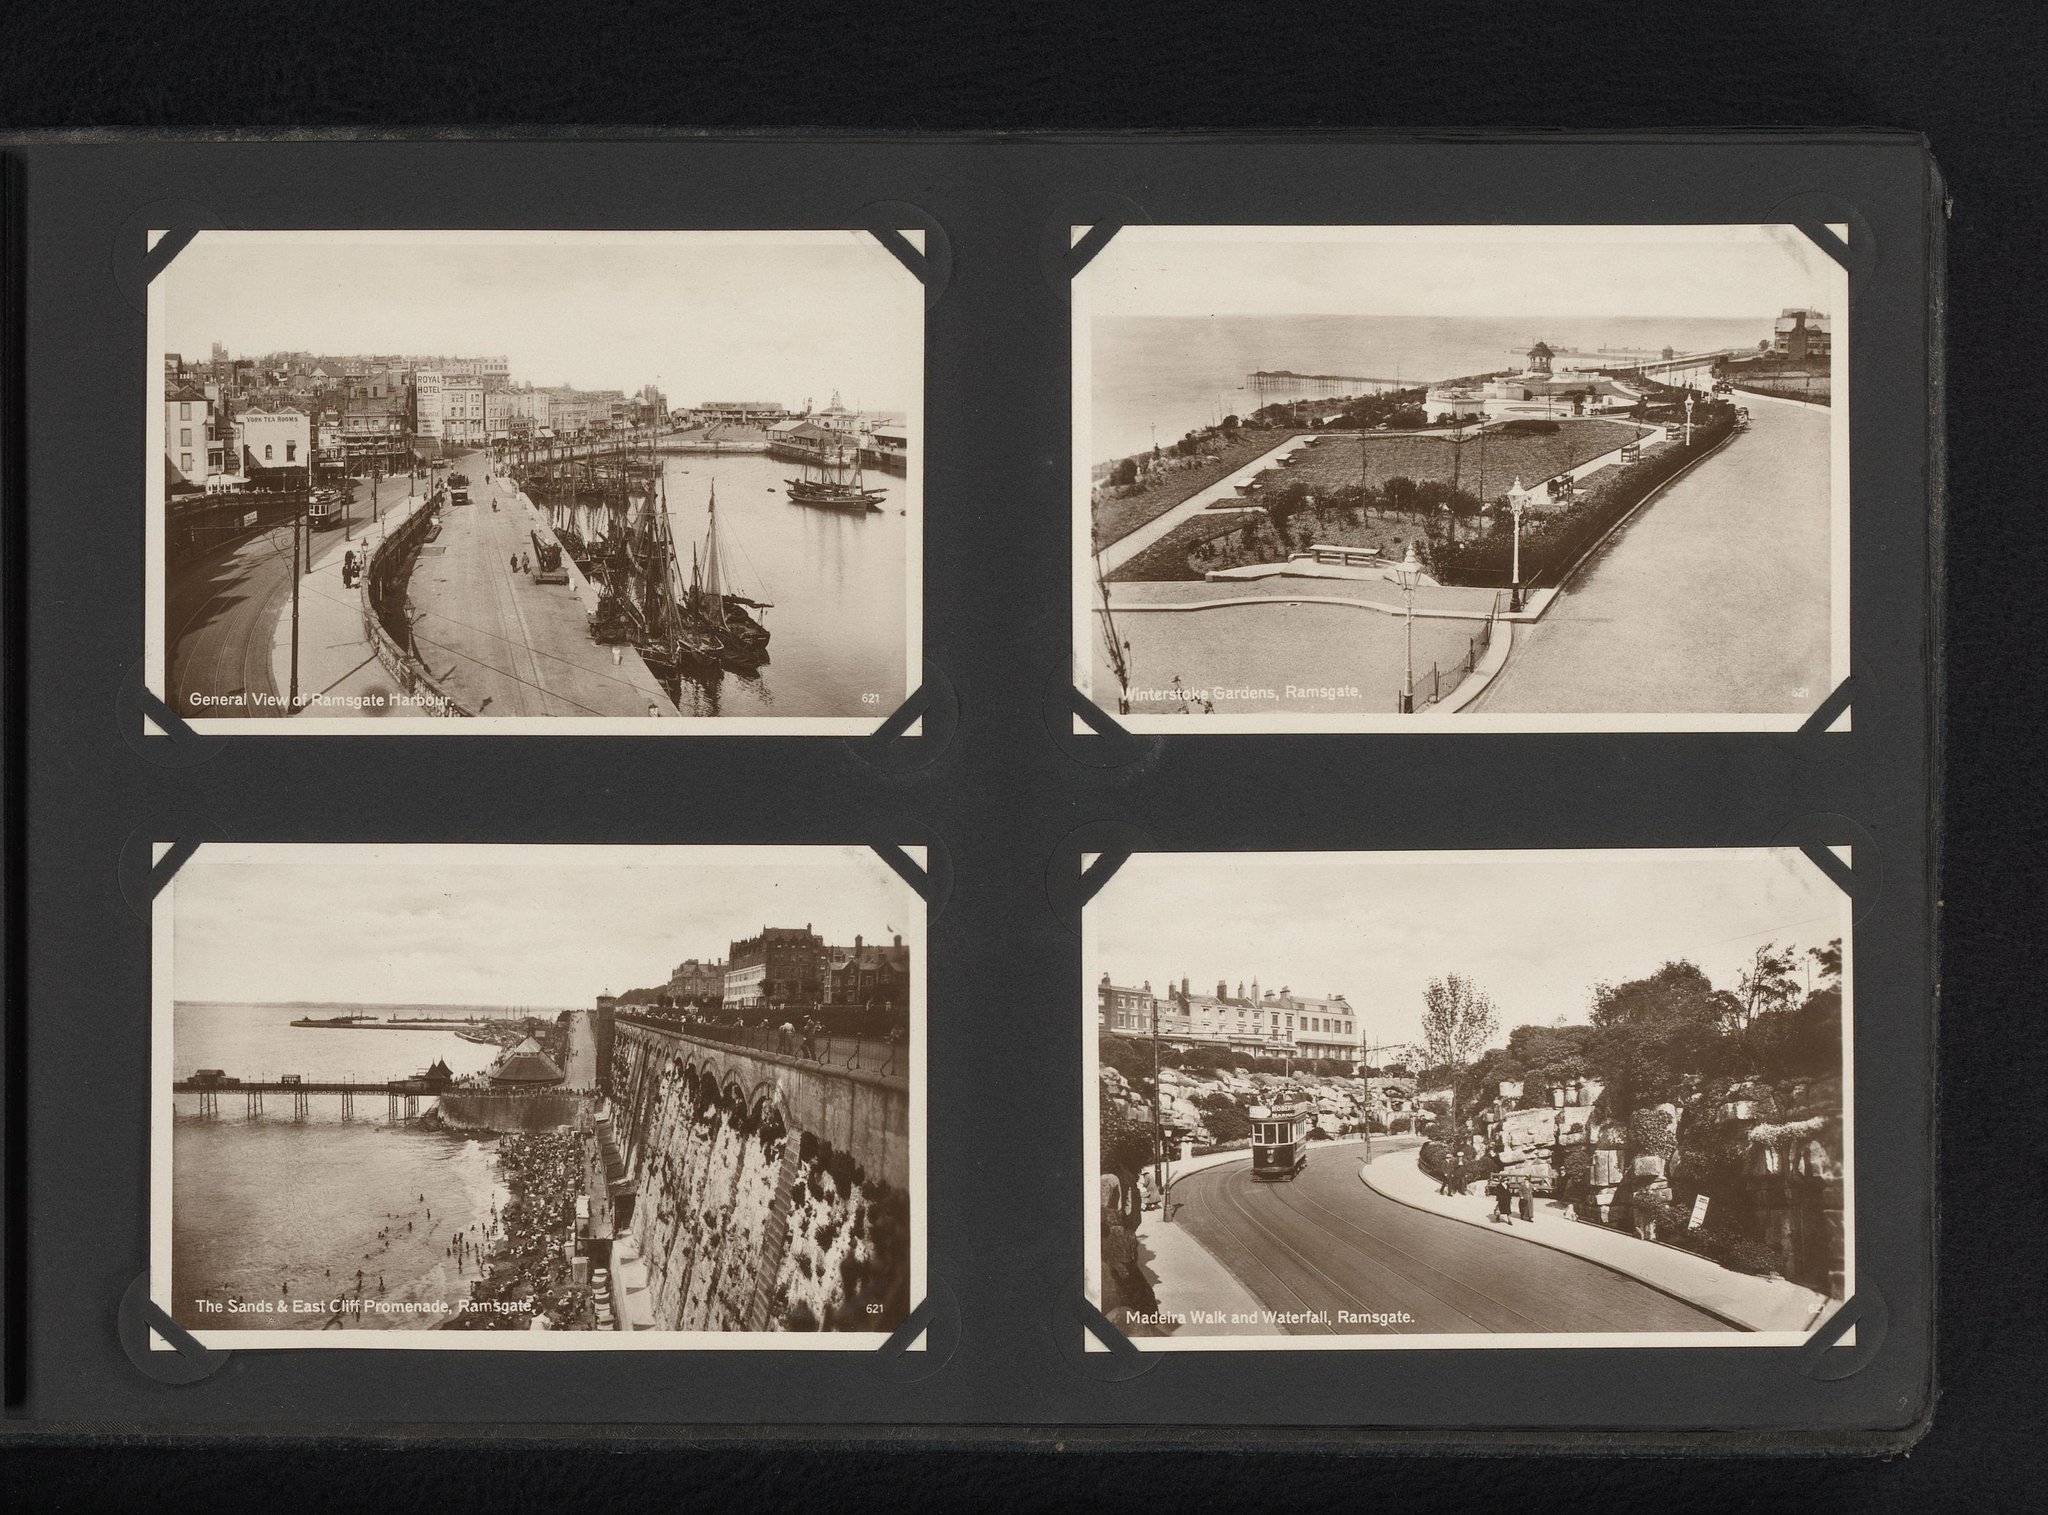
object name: album leaf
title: Vier fotografische prentbriefkaarten van Ramsgate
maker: Anonymous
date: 1926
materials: paper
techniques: gelatin silver print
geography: ramsgate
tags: city-view in general; 'veduta', avenue, boulevard, promenade, esplanade, coast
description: Deze foto's maken deel uit van een album.